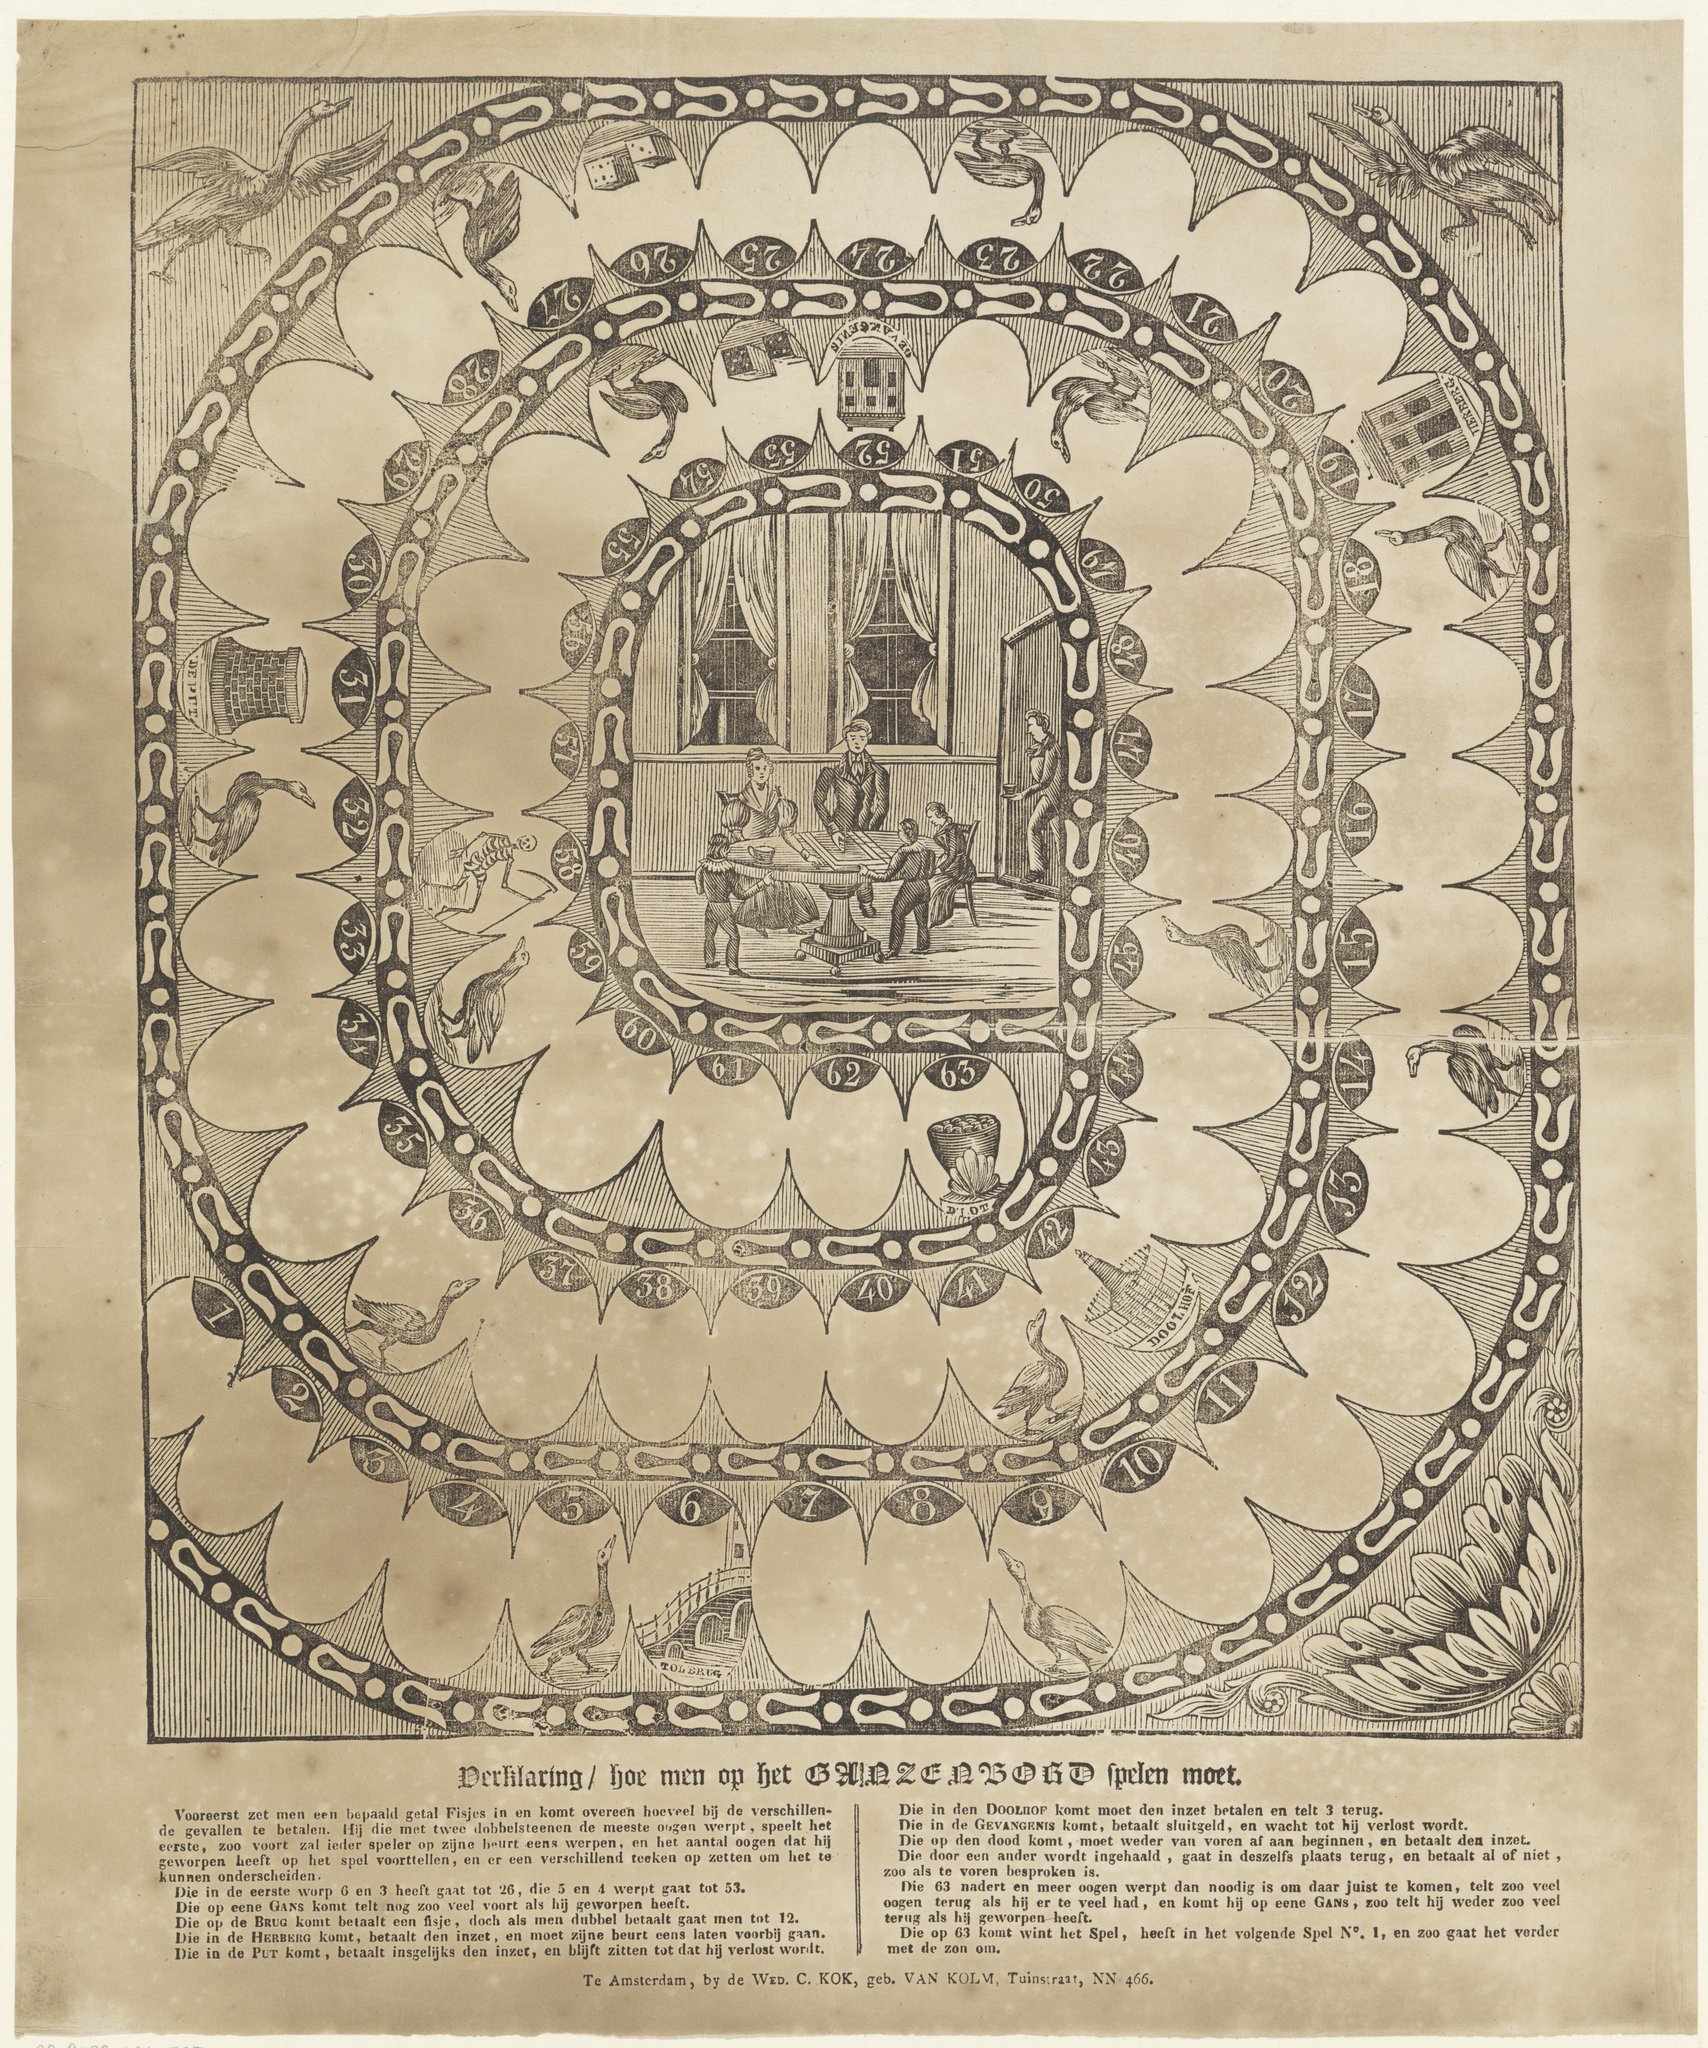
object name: popular print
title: Ganzenbordspel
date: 1842-1866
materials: paper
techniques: letterpress printing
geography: amsterdam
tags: goose-game, board-games of chance, board-games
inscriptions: collector's mark: Lugt 2760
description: Ganzenbordspel met vakjes in een spiraal, genummerd van 1 tot en met 63. Op het middenveld een voorstelling van een groep van twee volwassenen en drie kinderen die een spelletje spelen aan tafel. In de ondermarge de spelregels in twee kolommen.